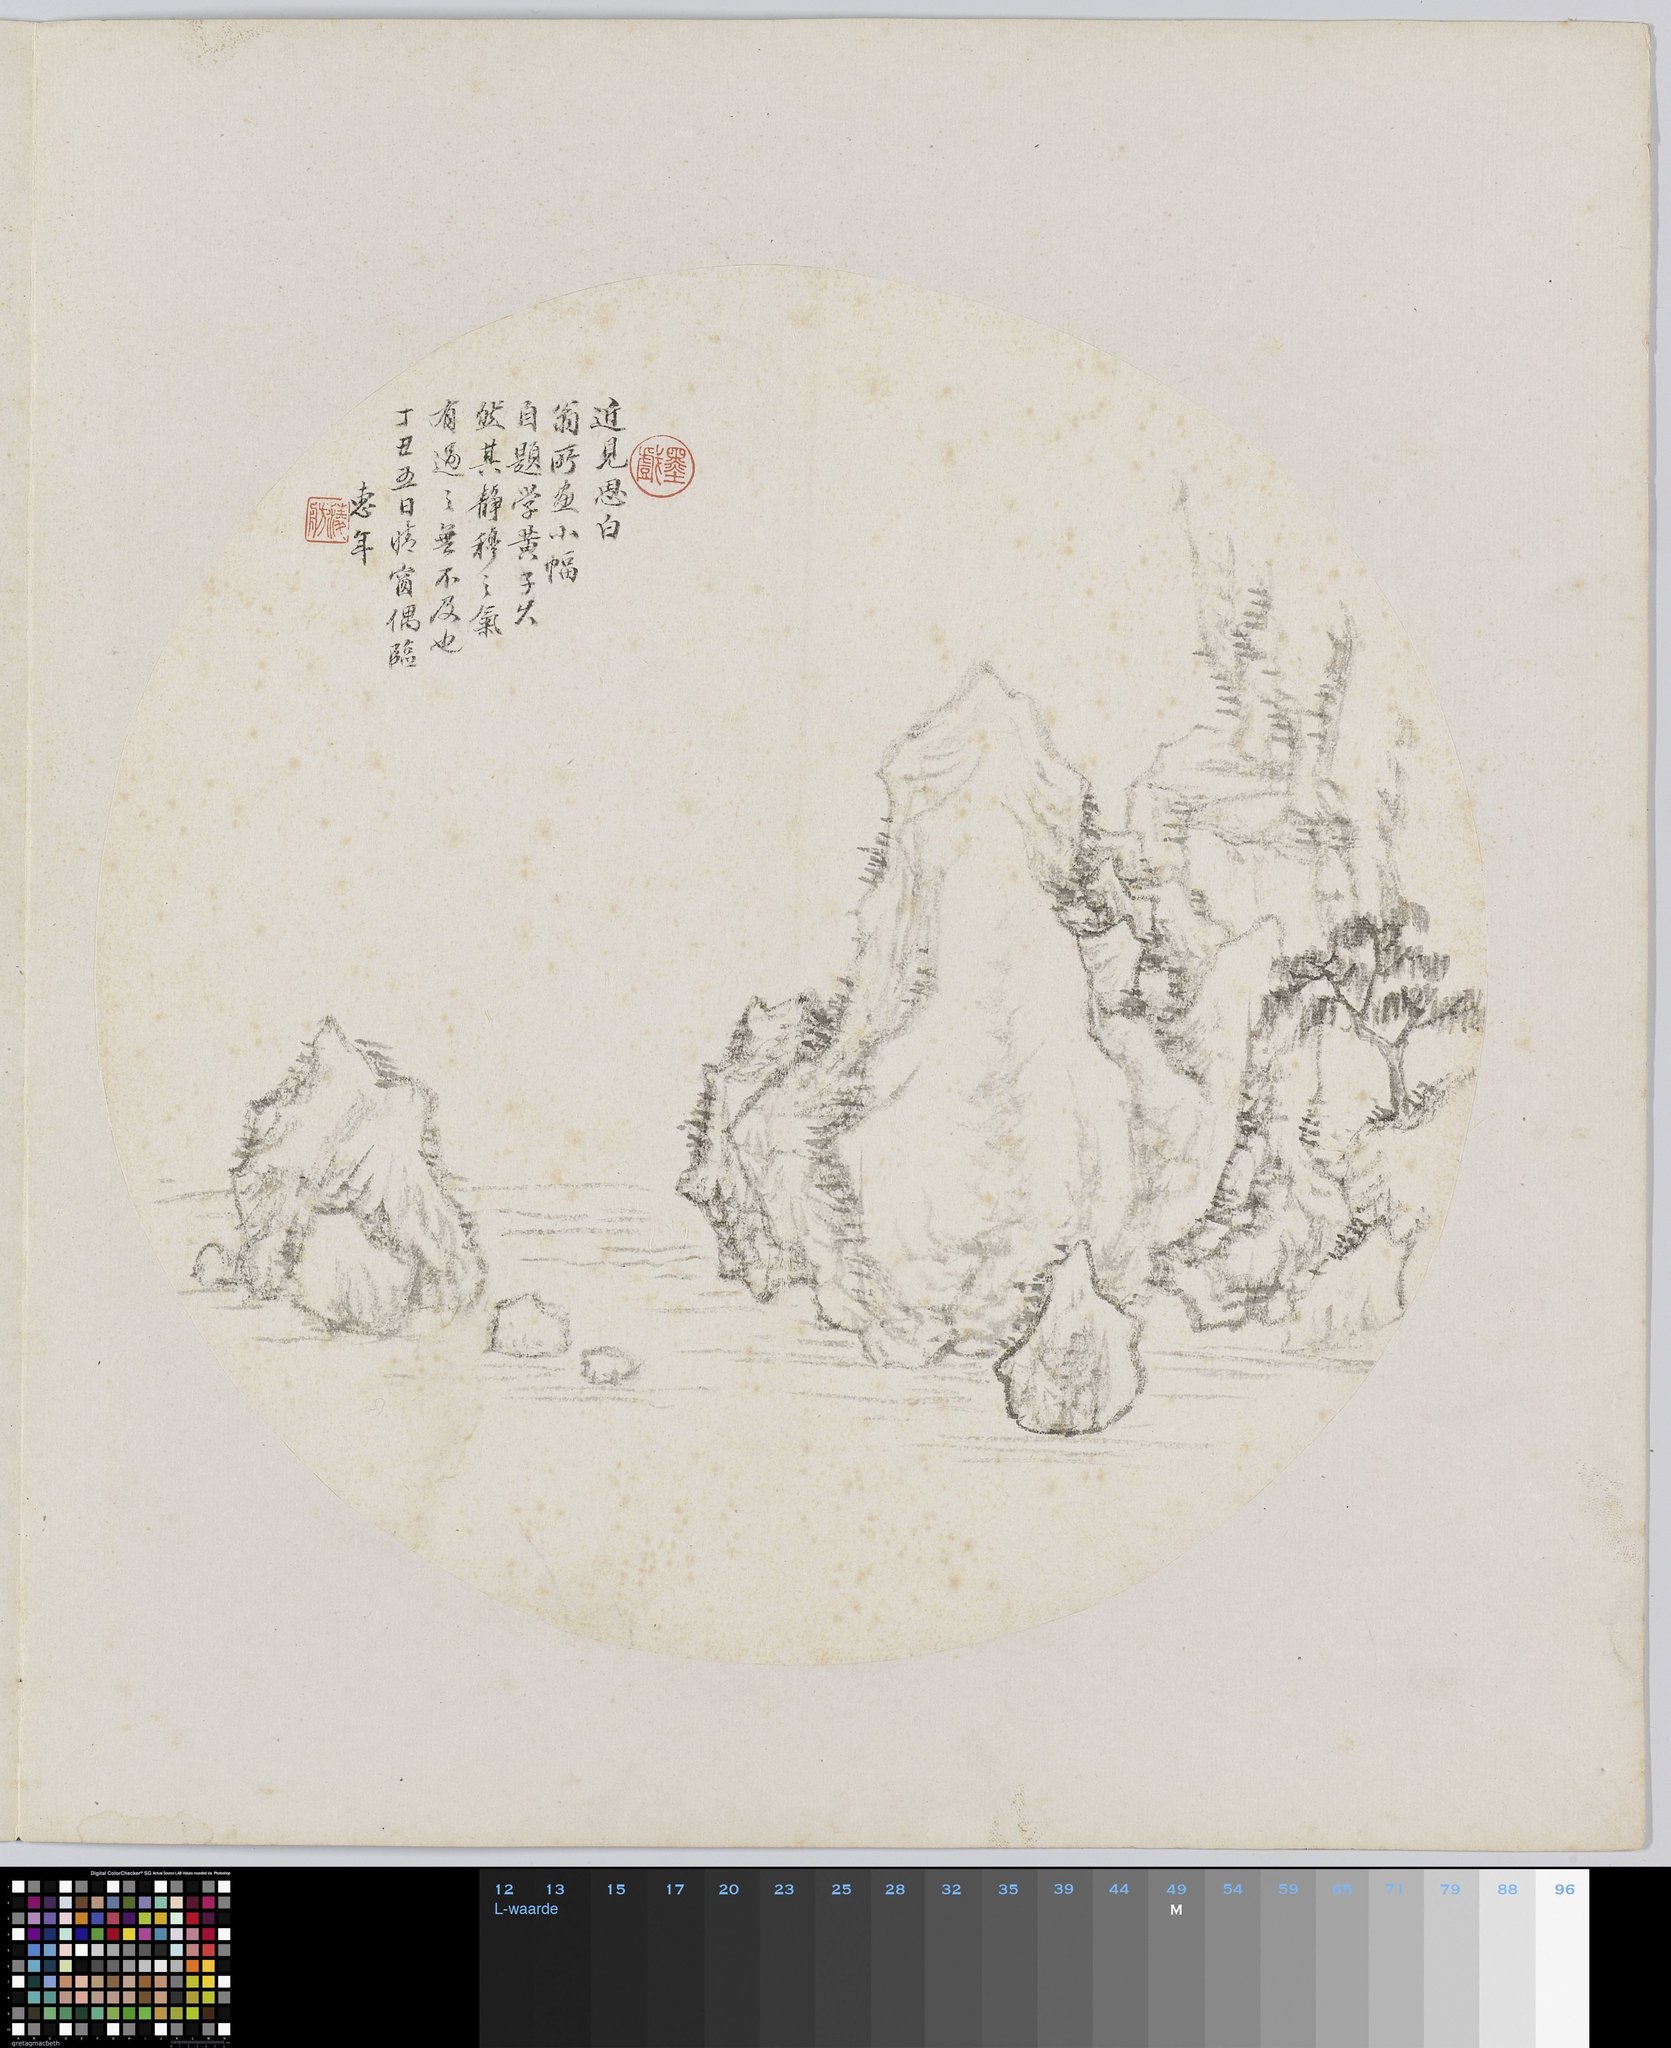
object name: painting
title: Albumblad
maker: hui nian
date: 1850-1900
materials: ink, paper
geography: china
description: Albumblad met een landschap. Behoort twee albums met 24 landschappen in de stijl van diverse meesters.